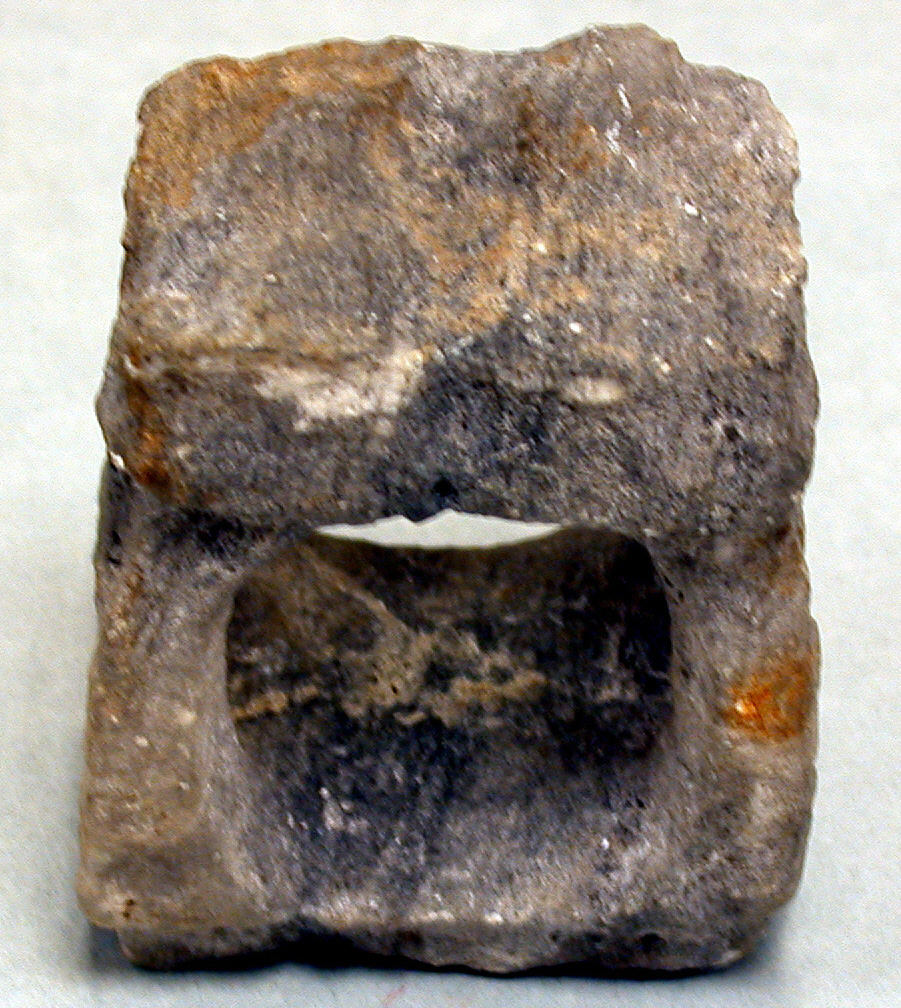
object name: architectural model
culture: mezcala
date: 1-800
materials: stone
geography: mexico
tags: temples